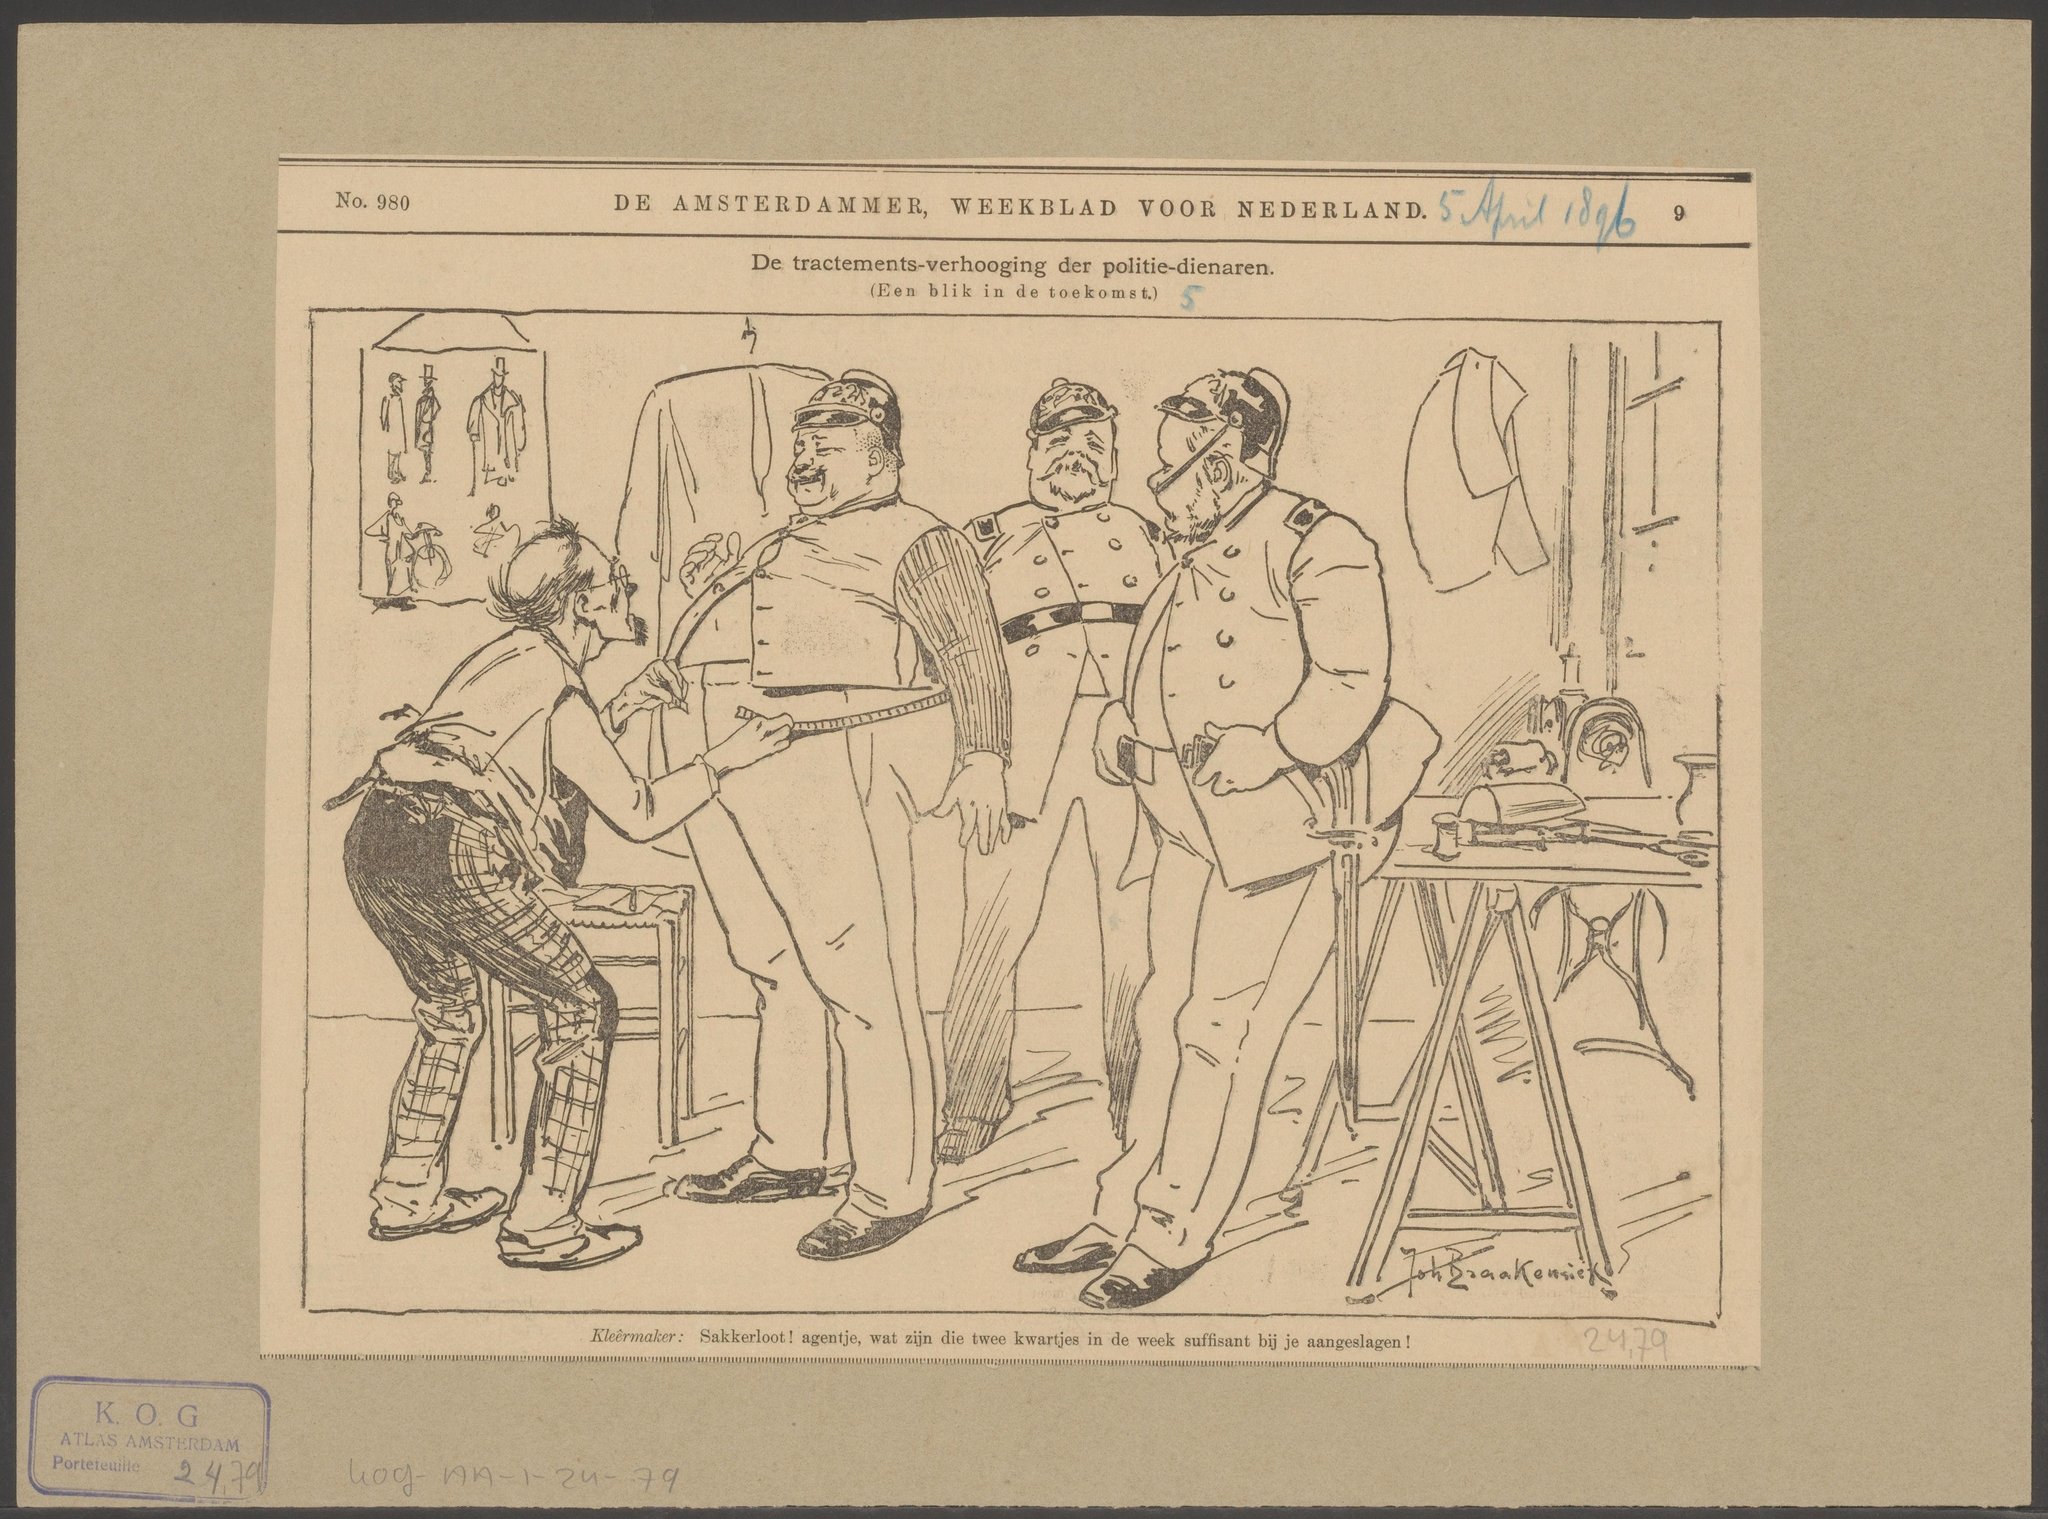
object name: cartoon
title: De tractements-verhooging der politie-dienaren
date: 1896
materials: paper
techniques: letterpress printing, line block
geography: netherlands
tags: policeman, constable, tailor, dressmaker, amsterdam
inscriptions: collector's mark: Lugt 1641b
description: Prent uit: De Amsterdammer 20 (1896), nr. 980, 5 april 1896, p. 9.